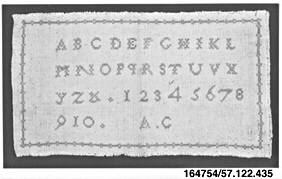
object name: sampler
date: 1801-1900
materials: cotton, linen